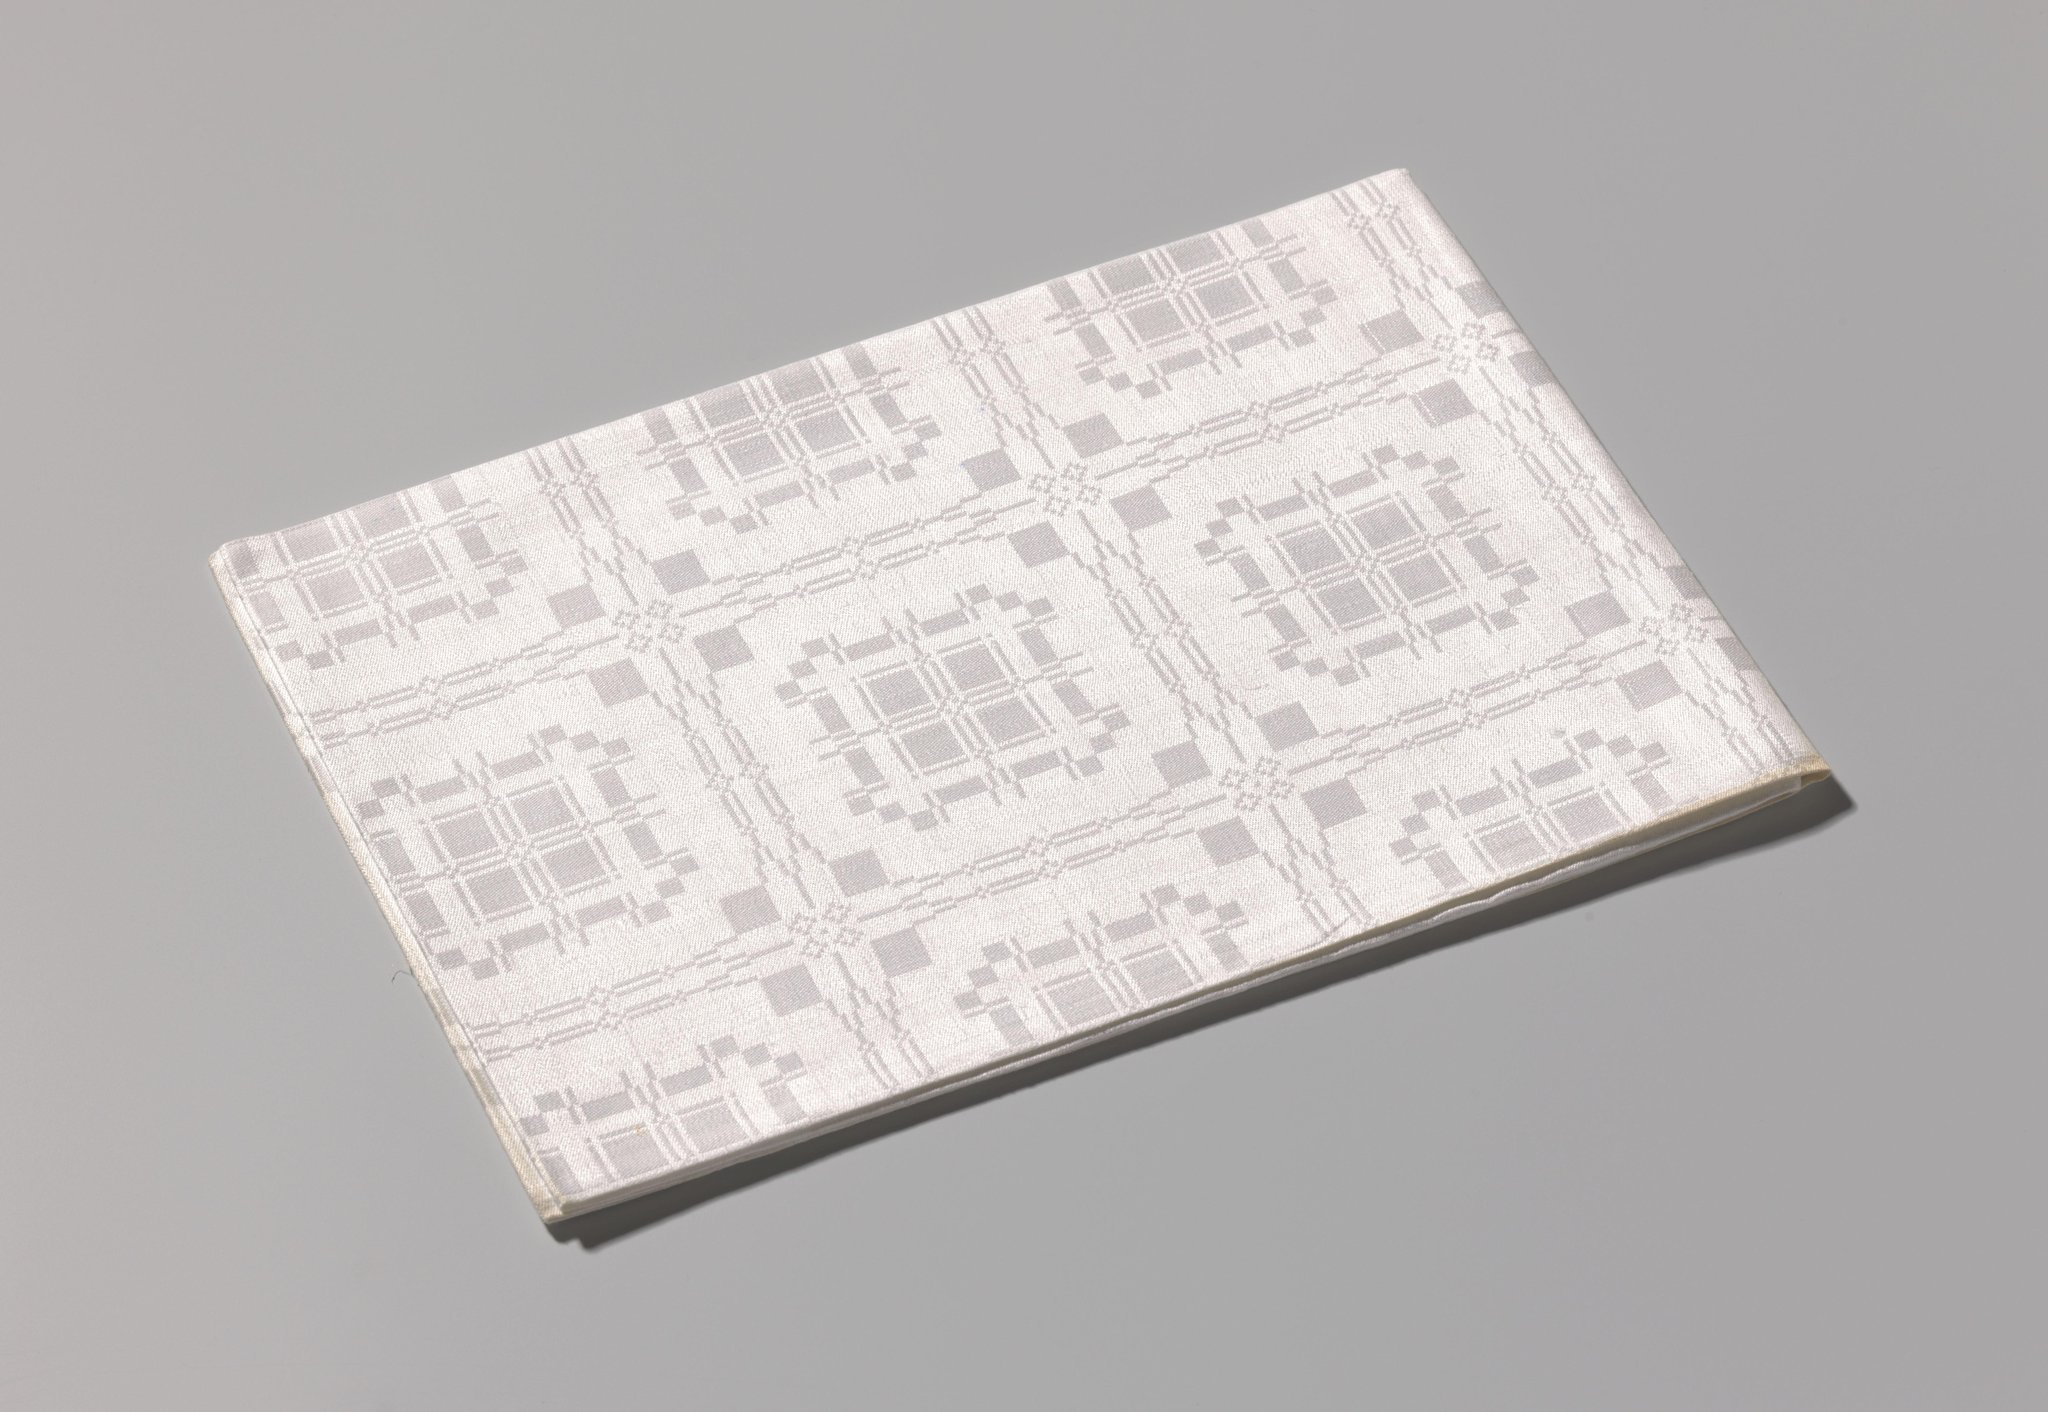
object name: napkin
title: Servet van linnen met pellenpatroon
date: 1400-1950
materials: linen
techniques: peeled fabric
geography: northern netherlands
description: Wit linnendamasten servet met pellenpatroon, merk kroon IS en 36.